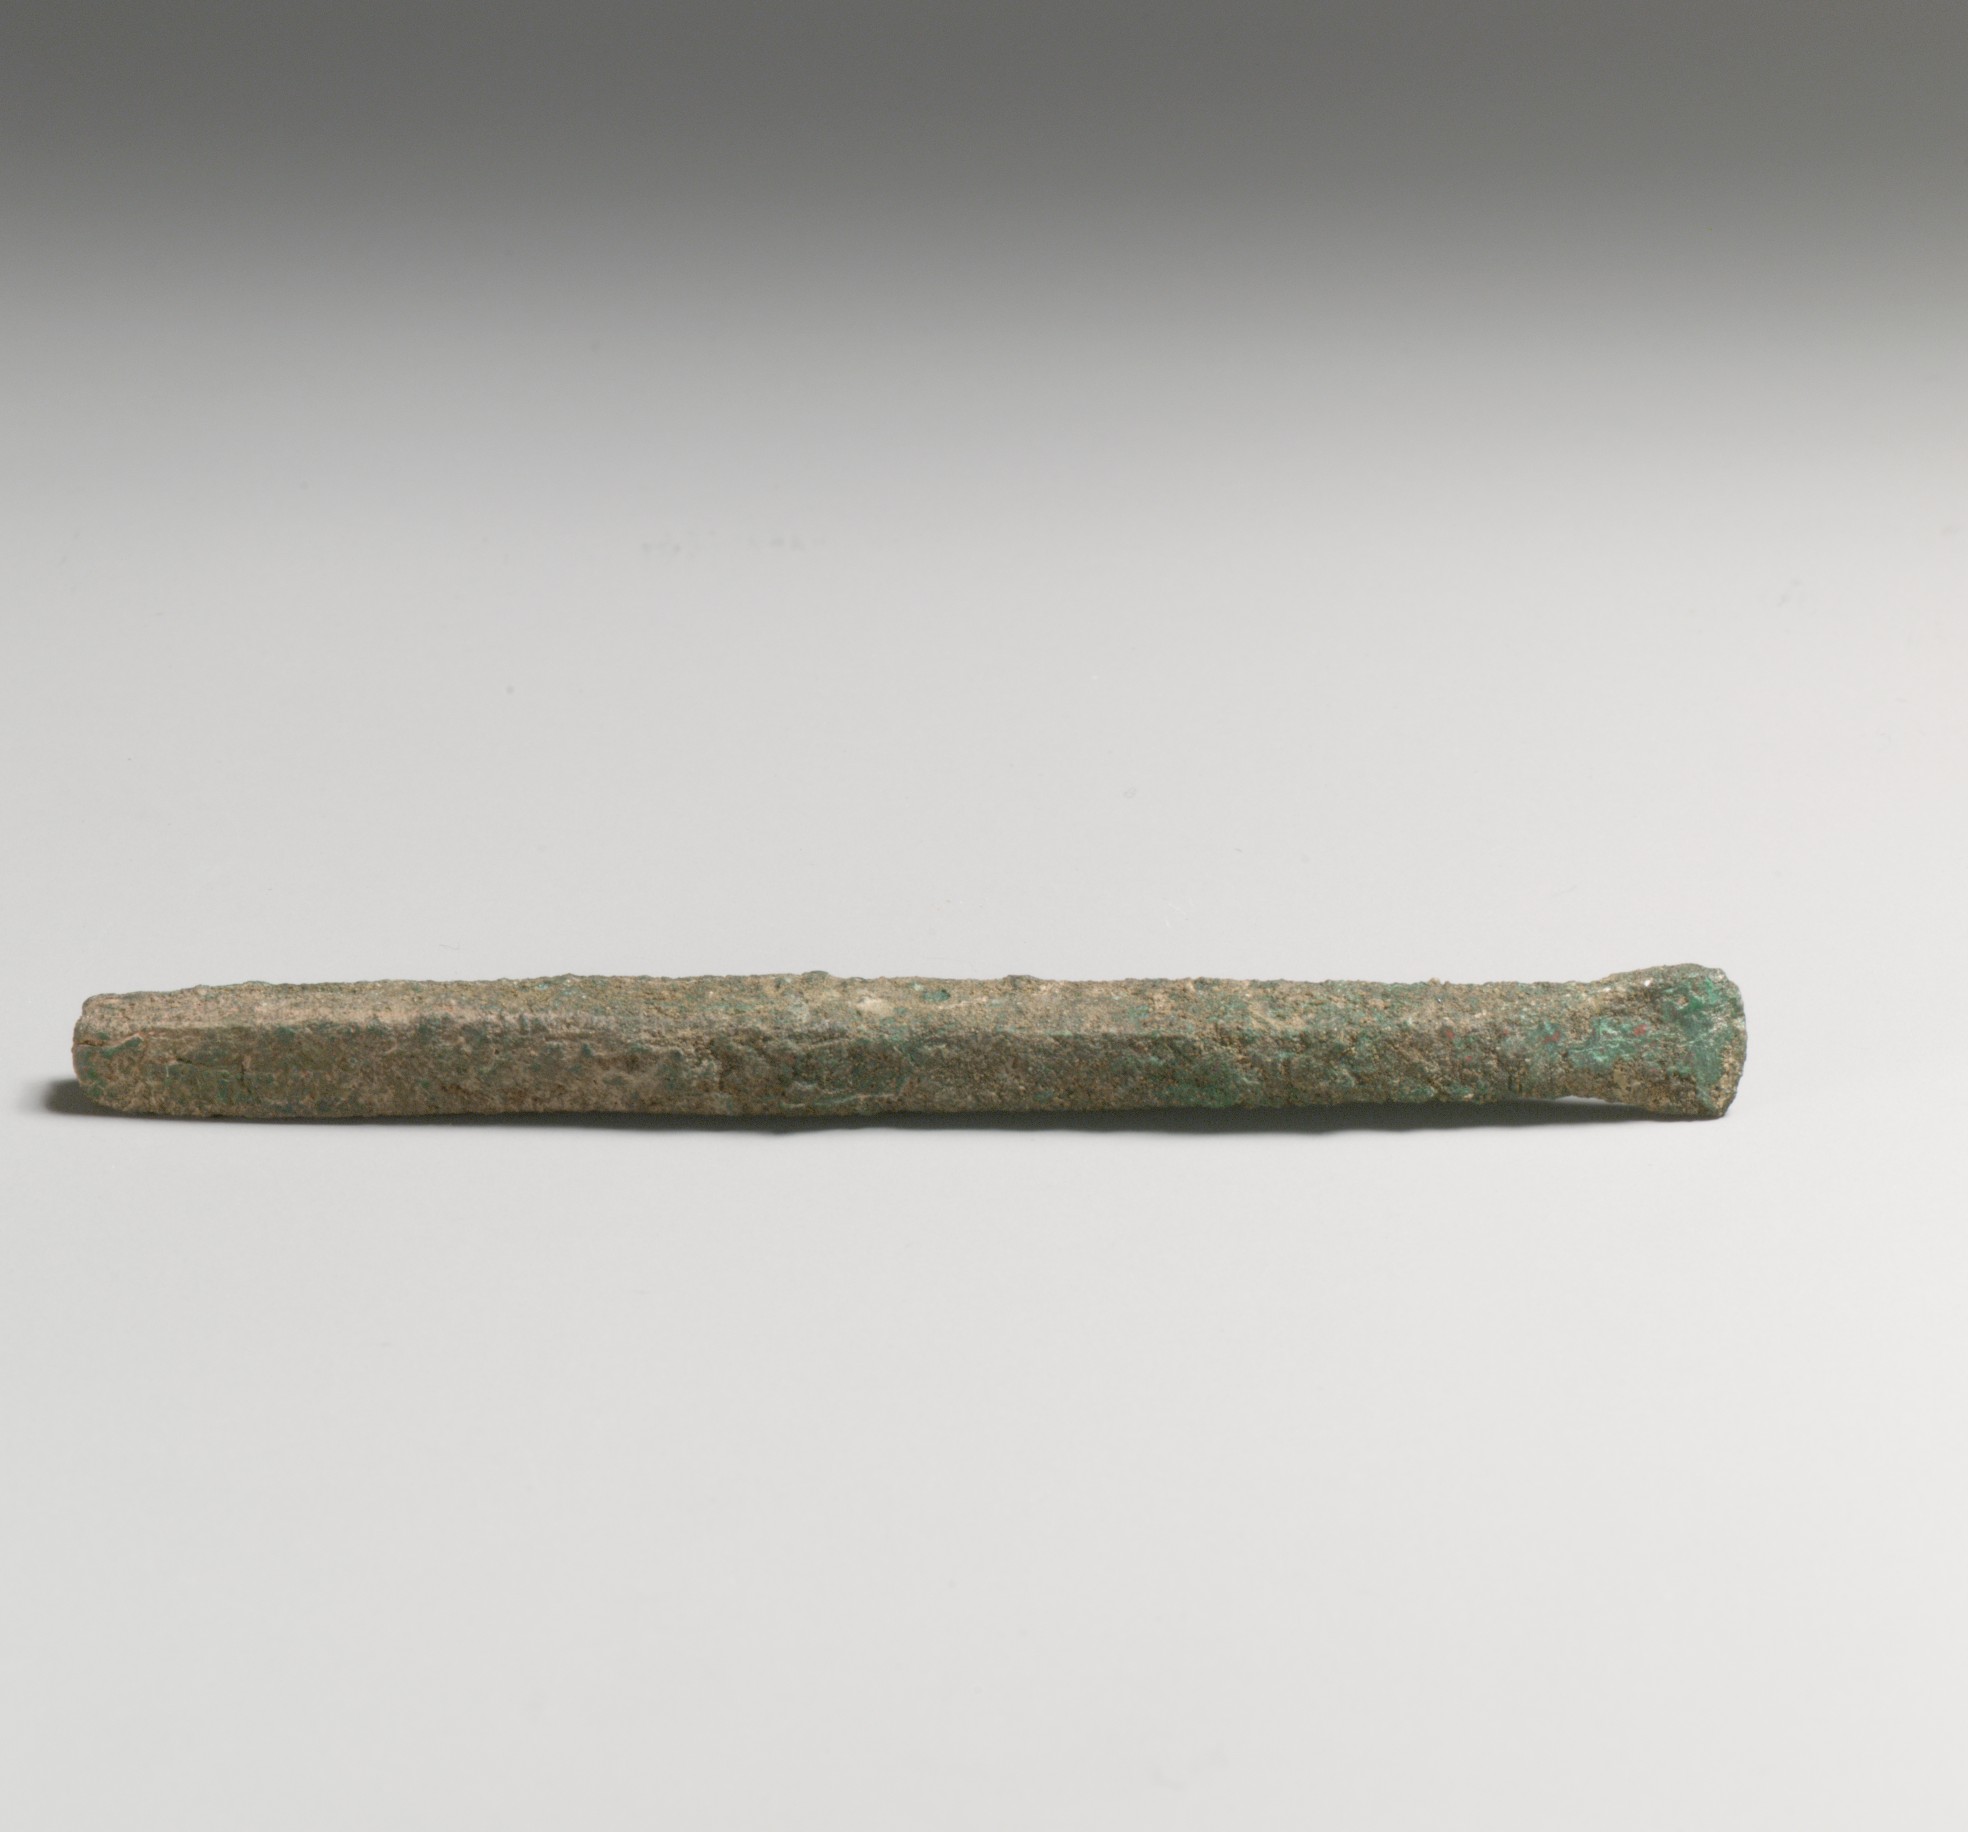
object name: chisel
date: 3000-2000 BCE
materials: bronze